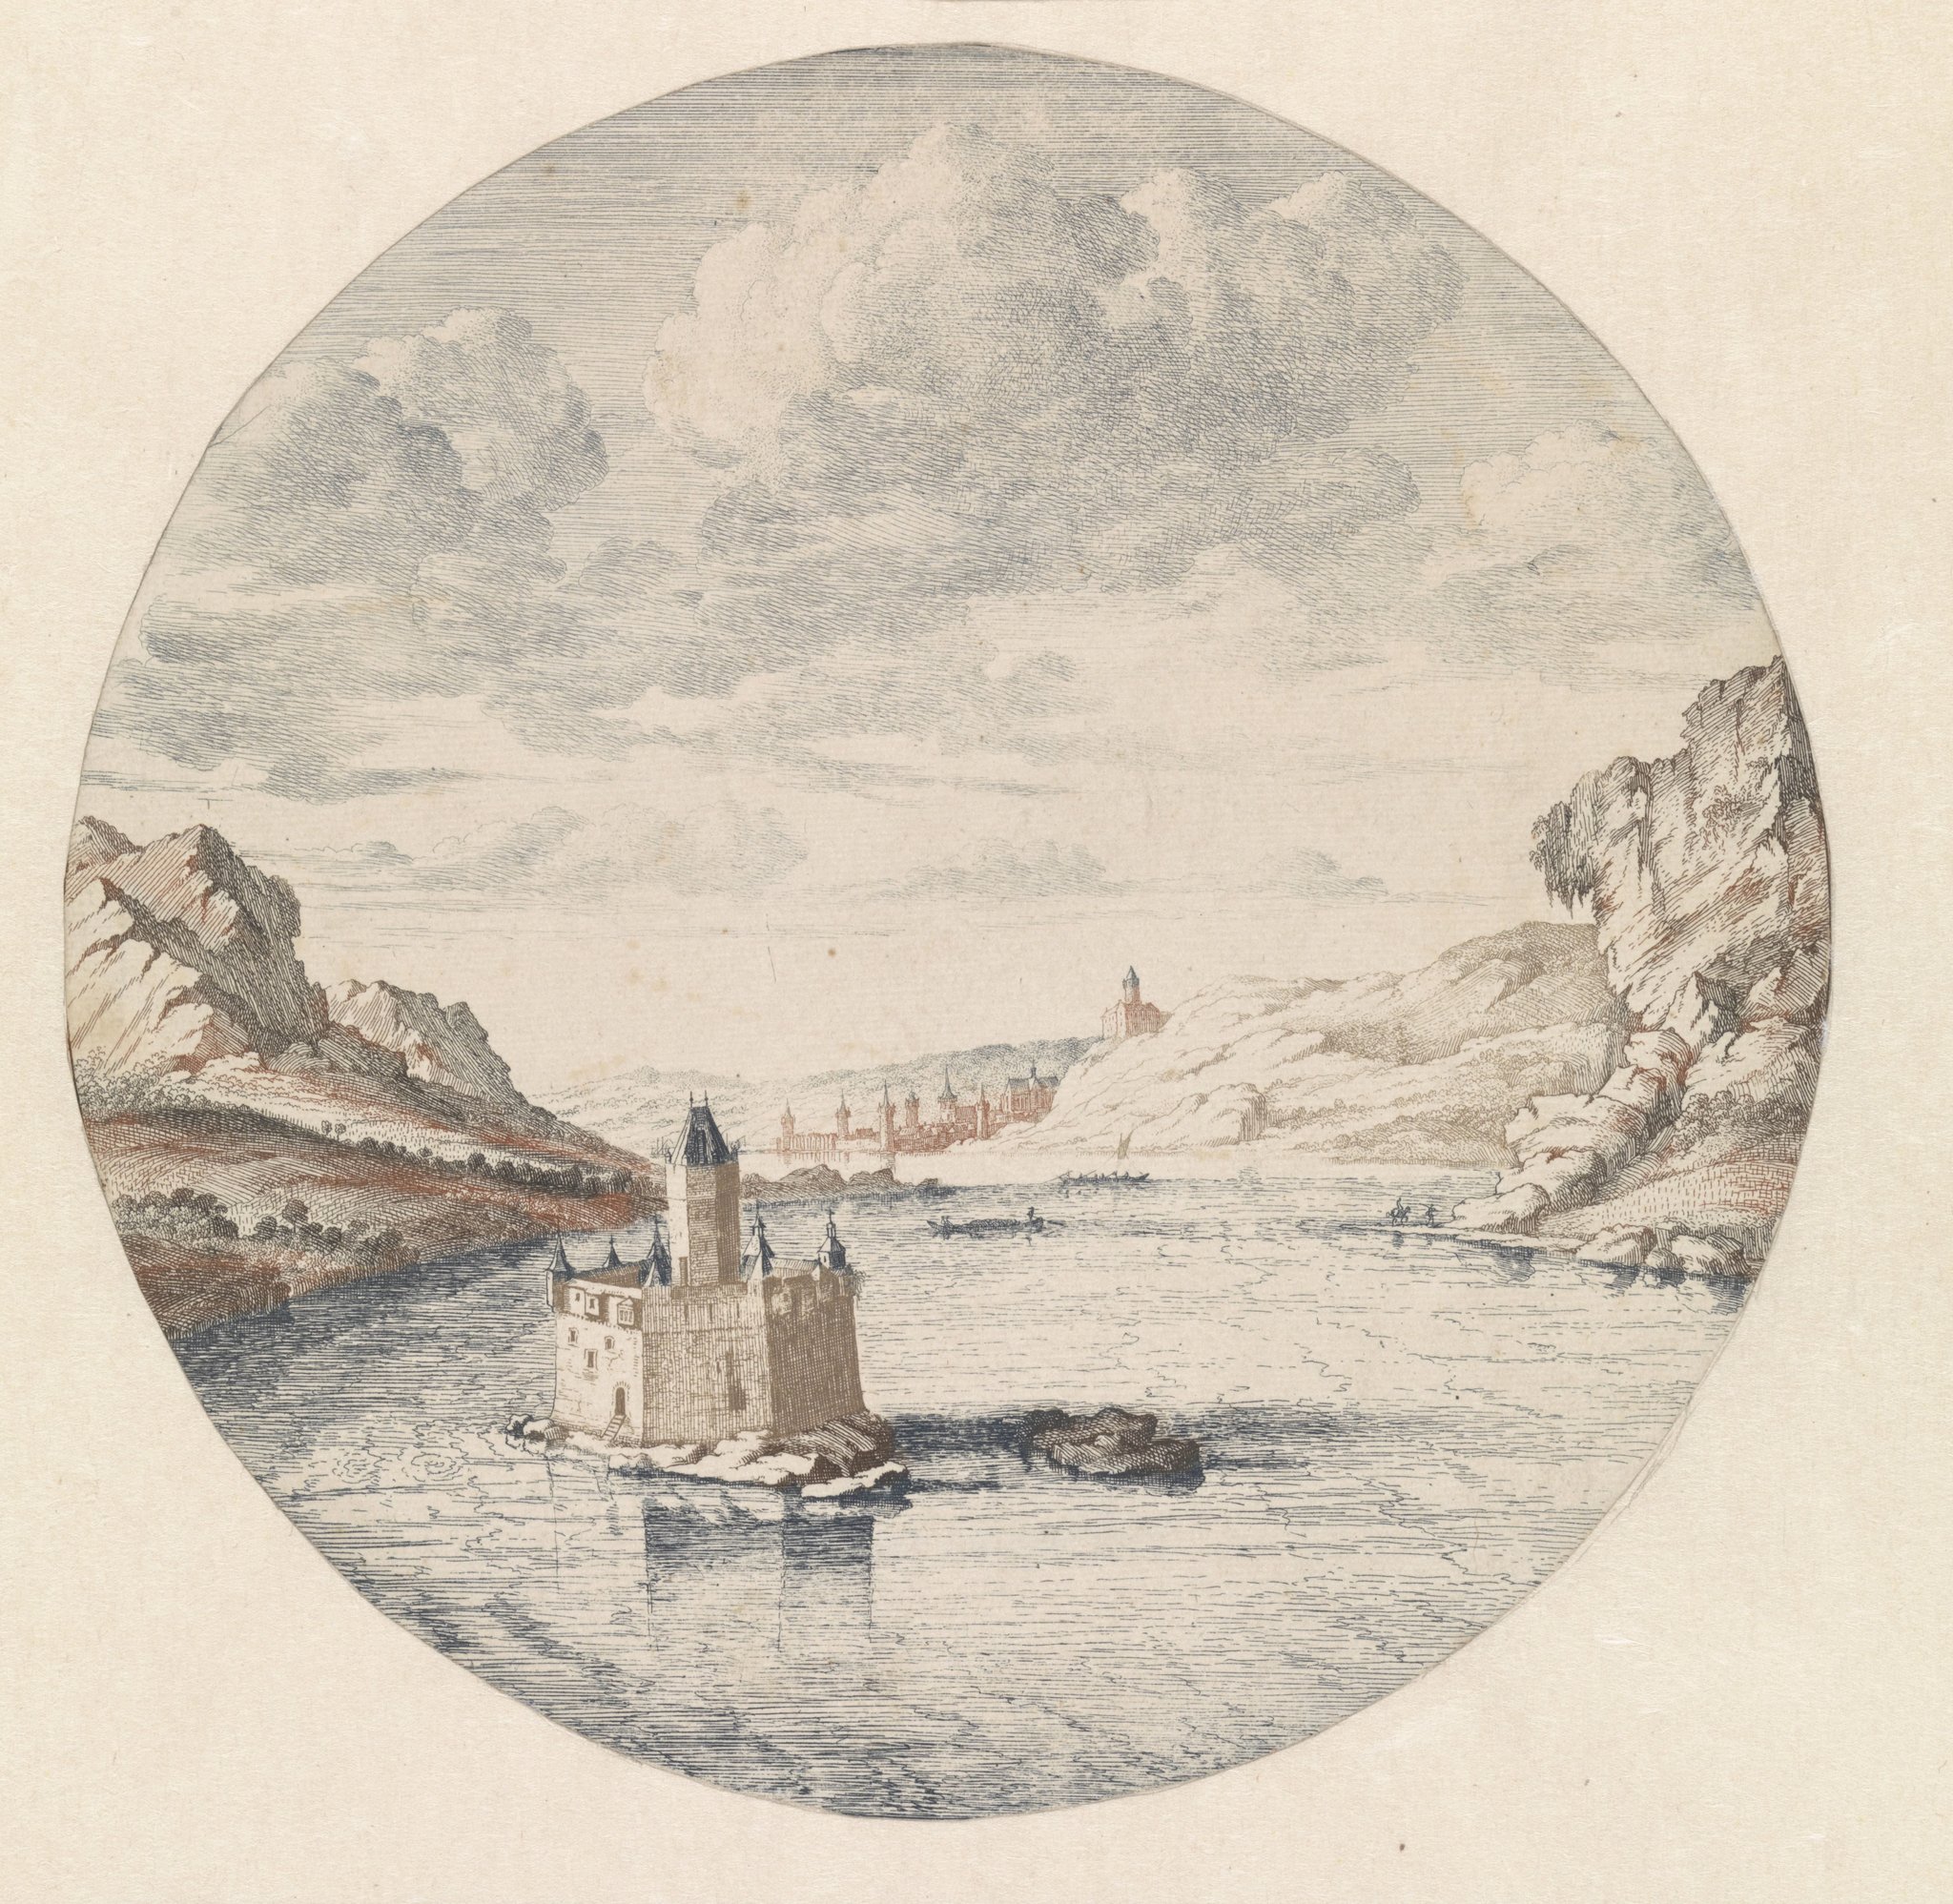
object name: print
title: Gezicht op burcht Pfalzgrafenstein bij Kaub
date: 1688-1698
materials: paper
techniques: etching, lithography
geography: netherlands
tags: fortress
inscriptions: collector's mark: Lugt 2233, collector's mark: Lugt 2228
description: Gezicht op de tolburcht Pfalzgrafenstein in de Rijn. Op de achtergrond de stad Kaub met daarboven op de heuvel burcht Gutenfels.